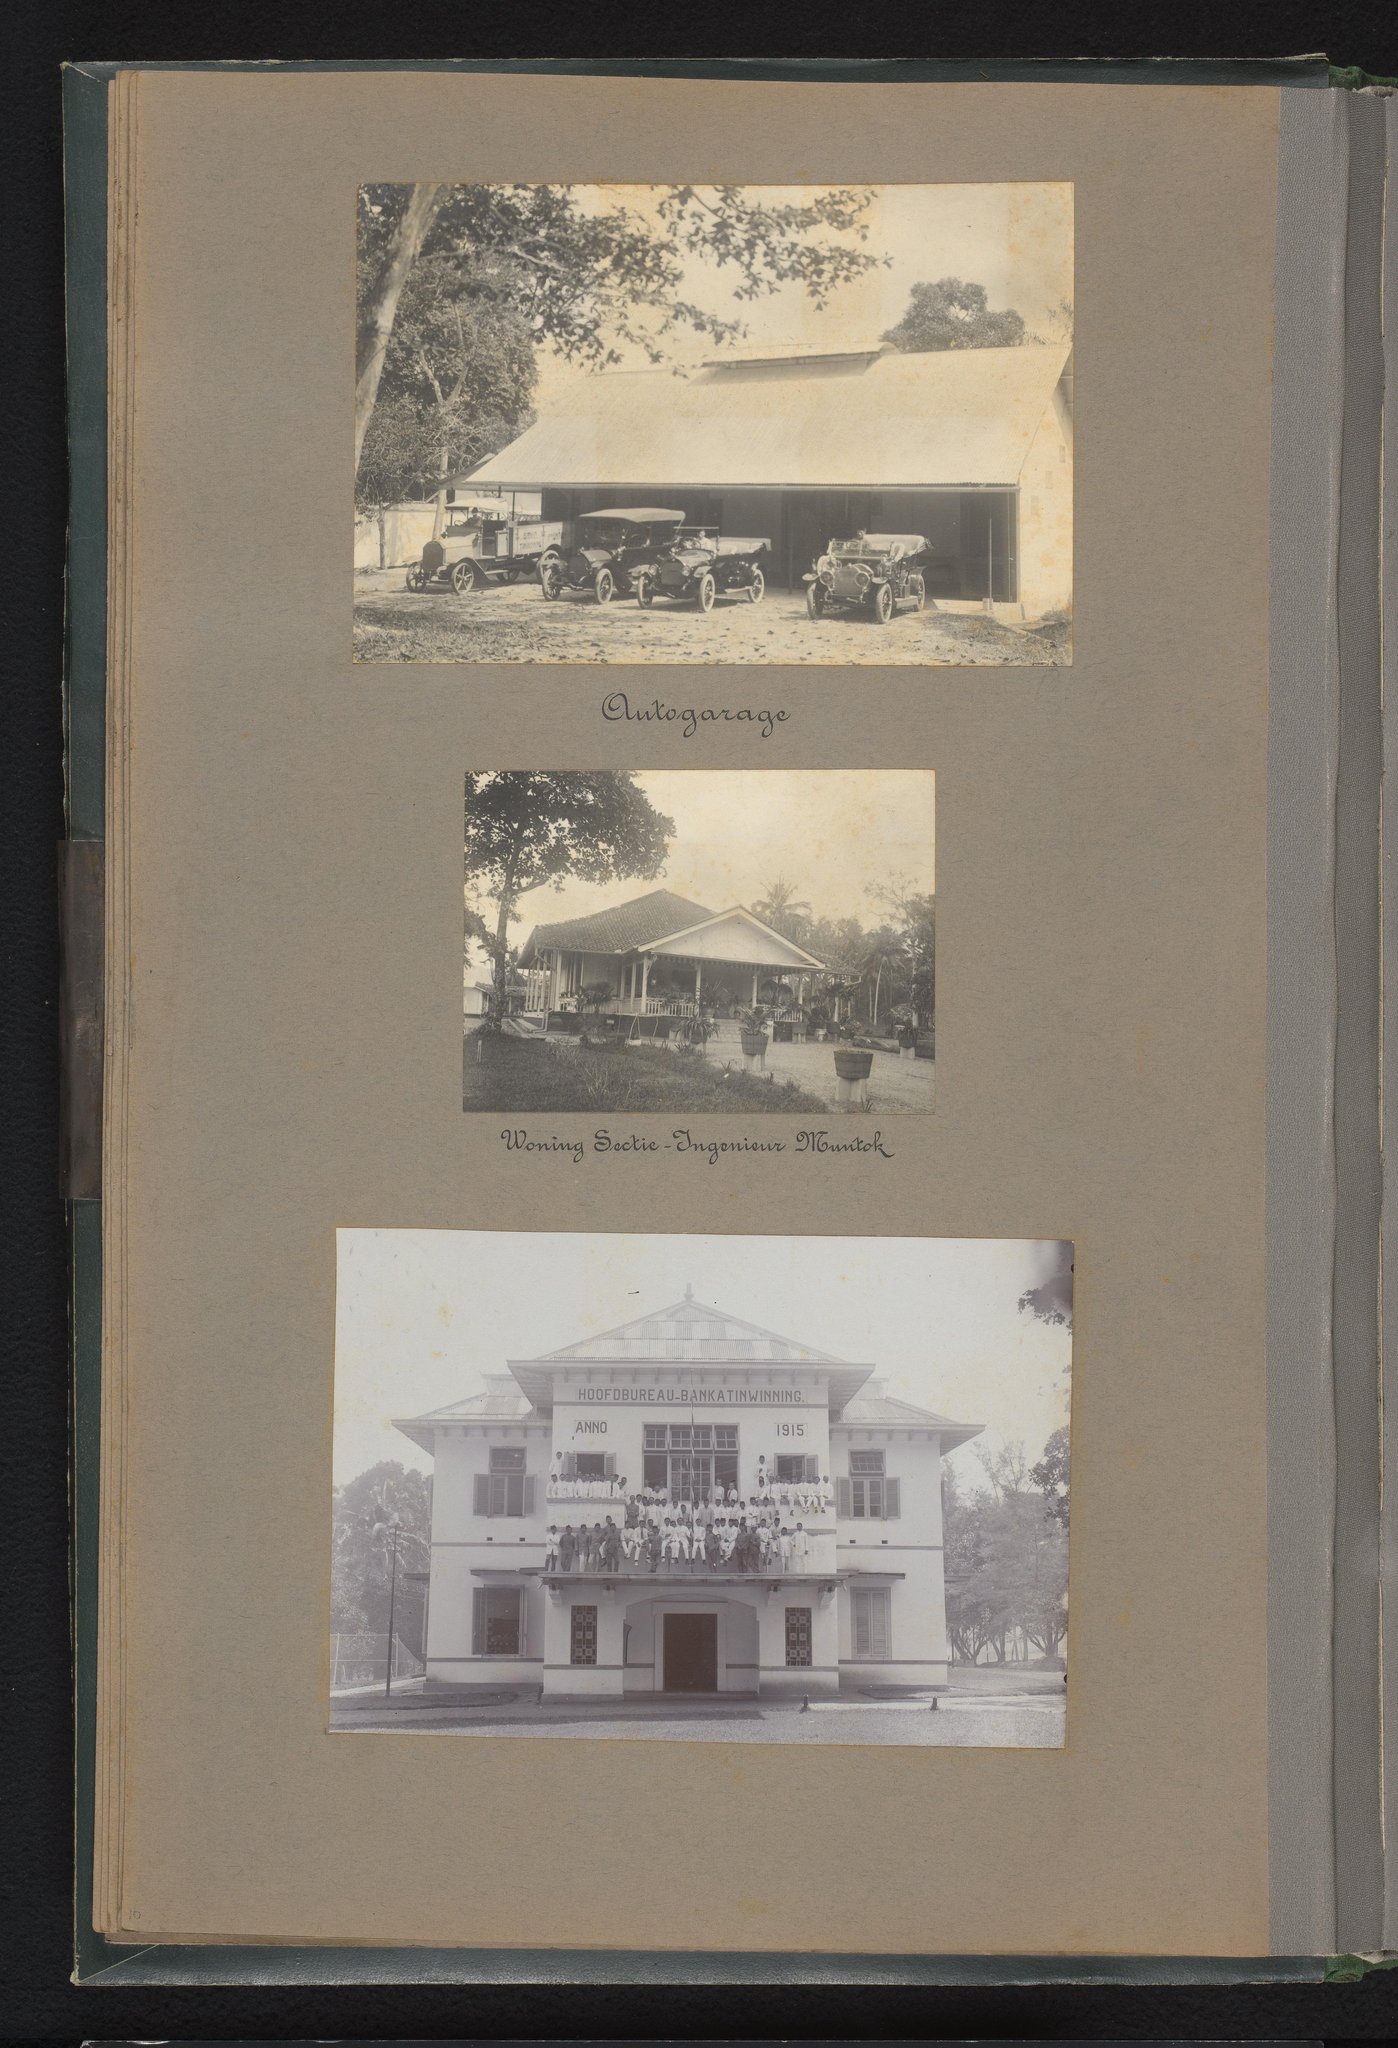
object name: album leaf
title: Gebouwen van de Banka-tinwinning, te Muntok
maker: Anonymous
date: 1914-1919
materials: cardboard, photographic support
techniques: gelatin silver print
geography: bangka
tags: robert julius boers, colonial system, mining, garage, villa, automobile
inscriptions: inscription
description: Albumblad met drie foto's van gebouwen van de Banka-tinwinning te Muntok. Onderdeel van het fotoalbum aangeboden aan Robert Julius Boers bij zijn vertrek naar Nederland in 1919 door het personeel van de Banka-tinwinning.